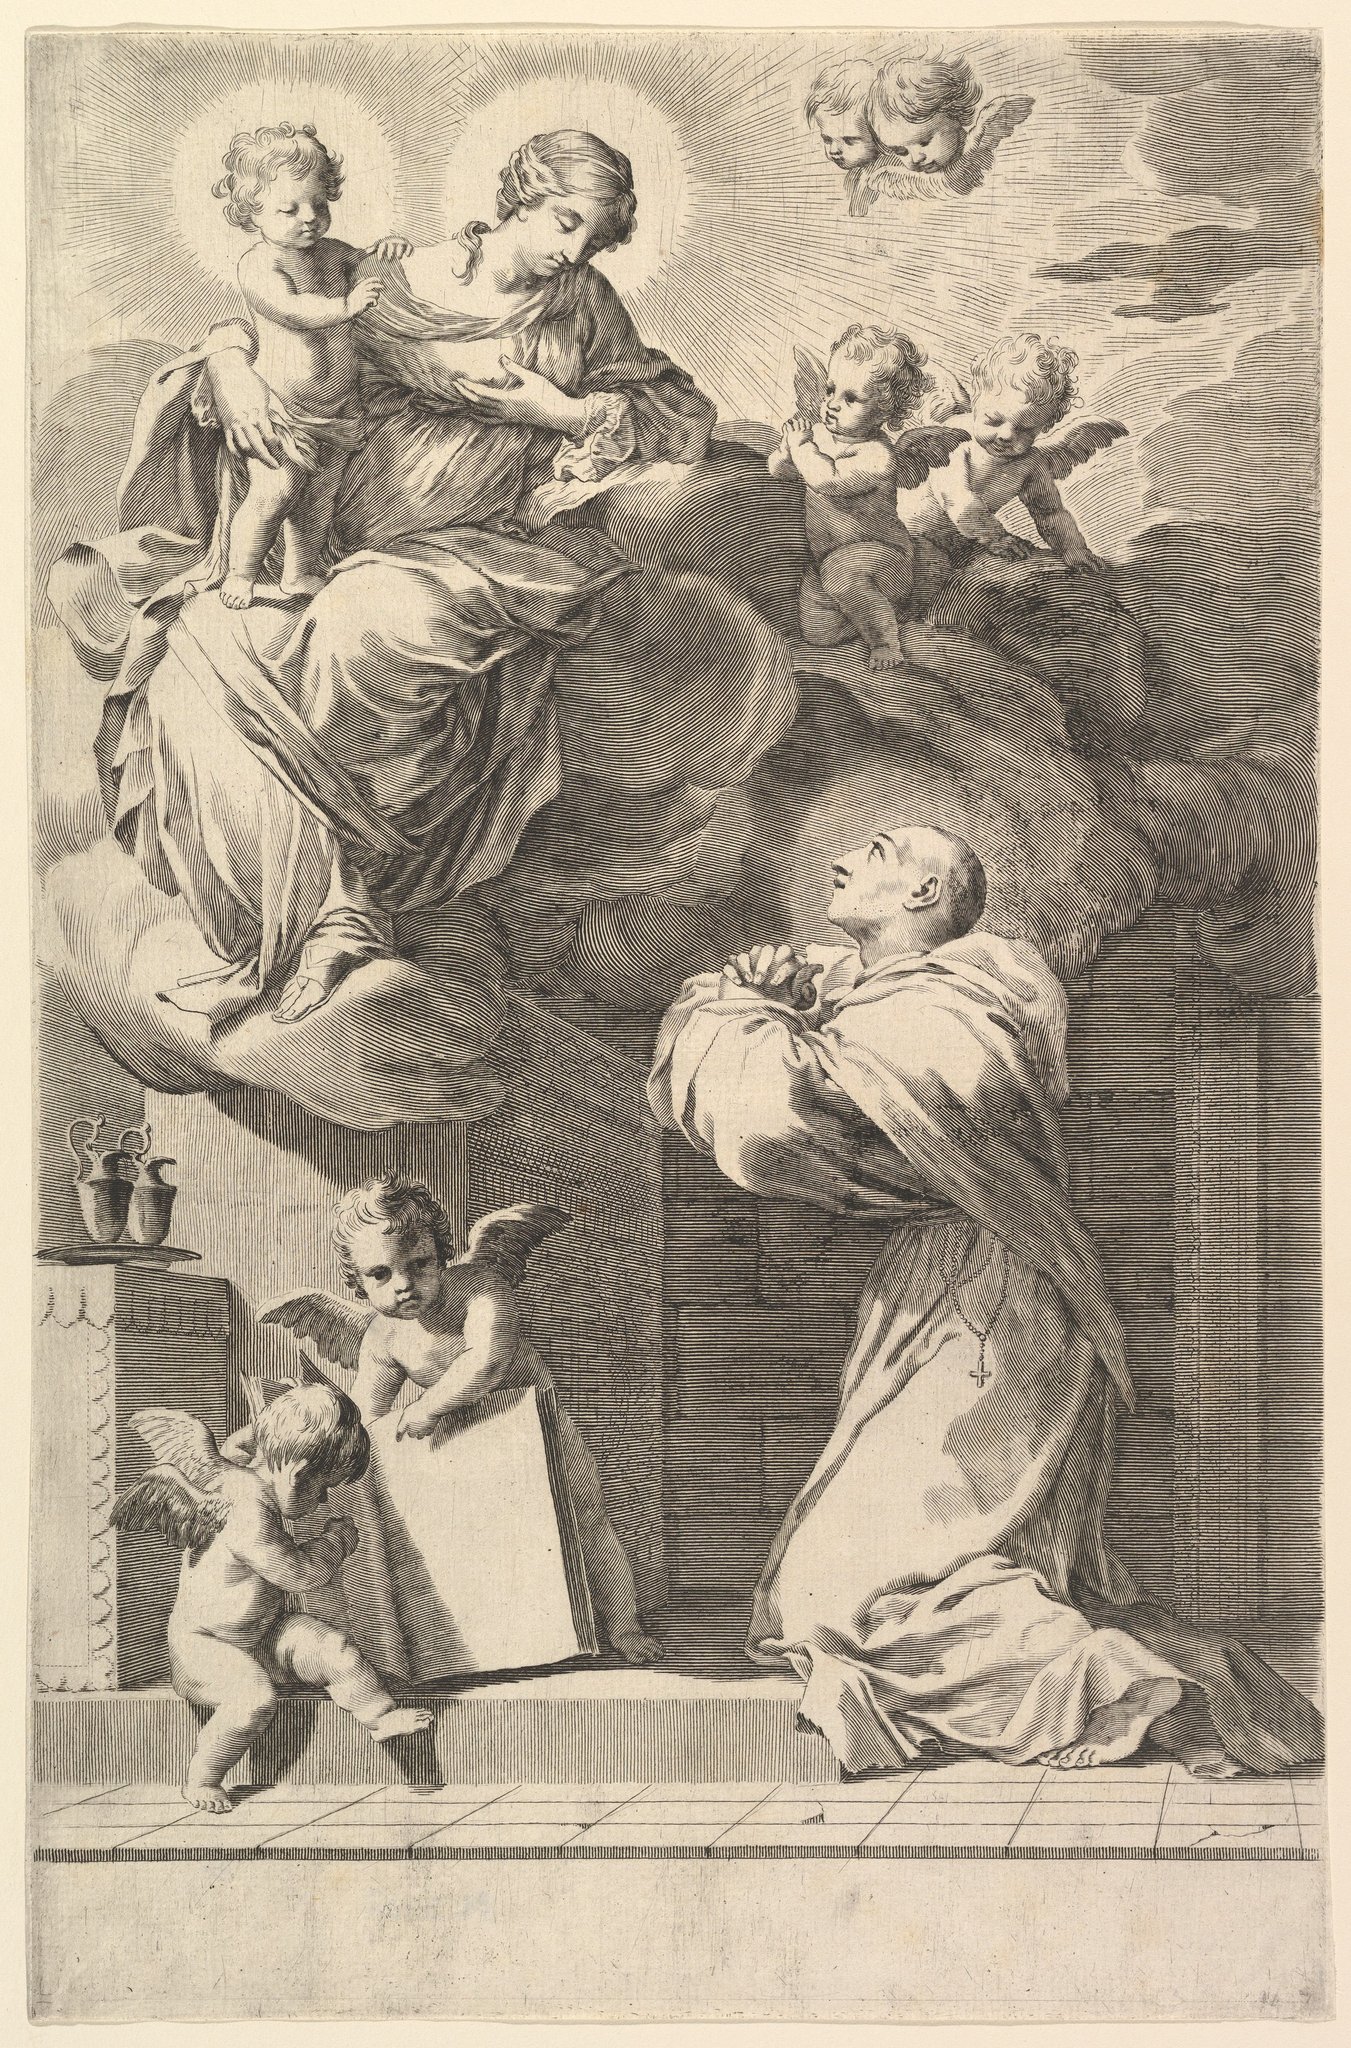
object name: print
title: Saint Bernard Kneeling before the Virgin and Child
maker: claude mellan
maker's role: artist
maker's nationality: french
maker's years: 1598-1688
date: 1640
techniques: engraving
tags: men,angels,madonna and child,saints